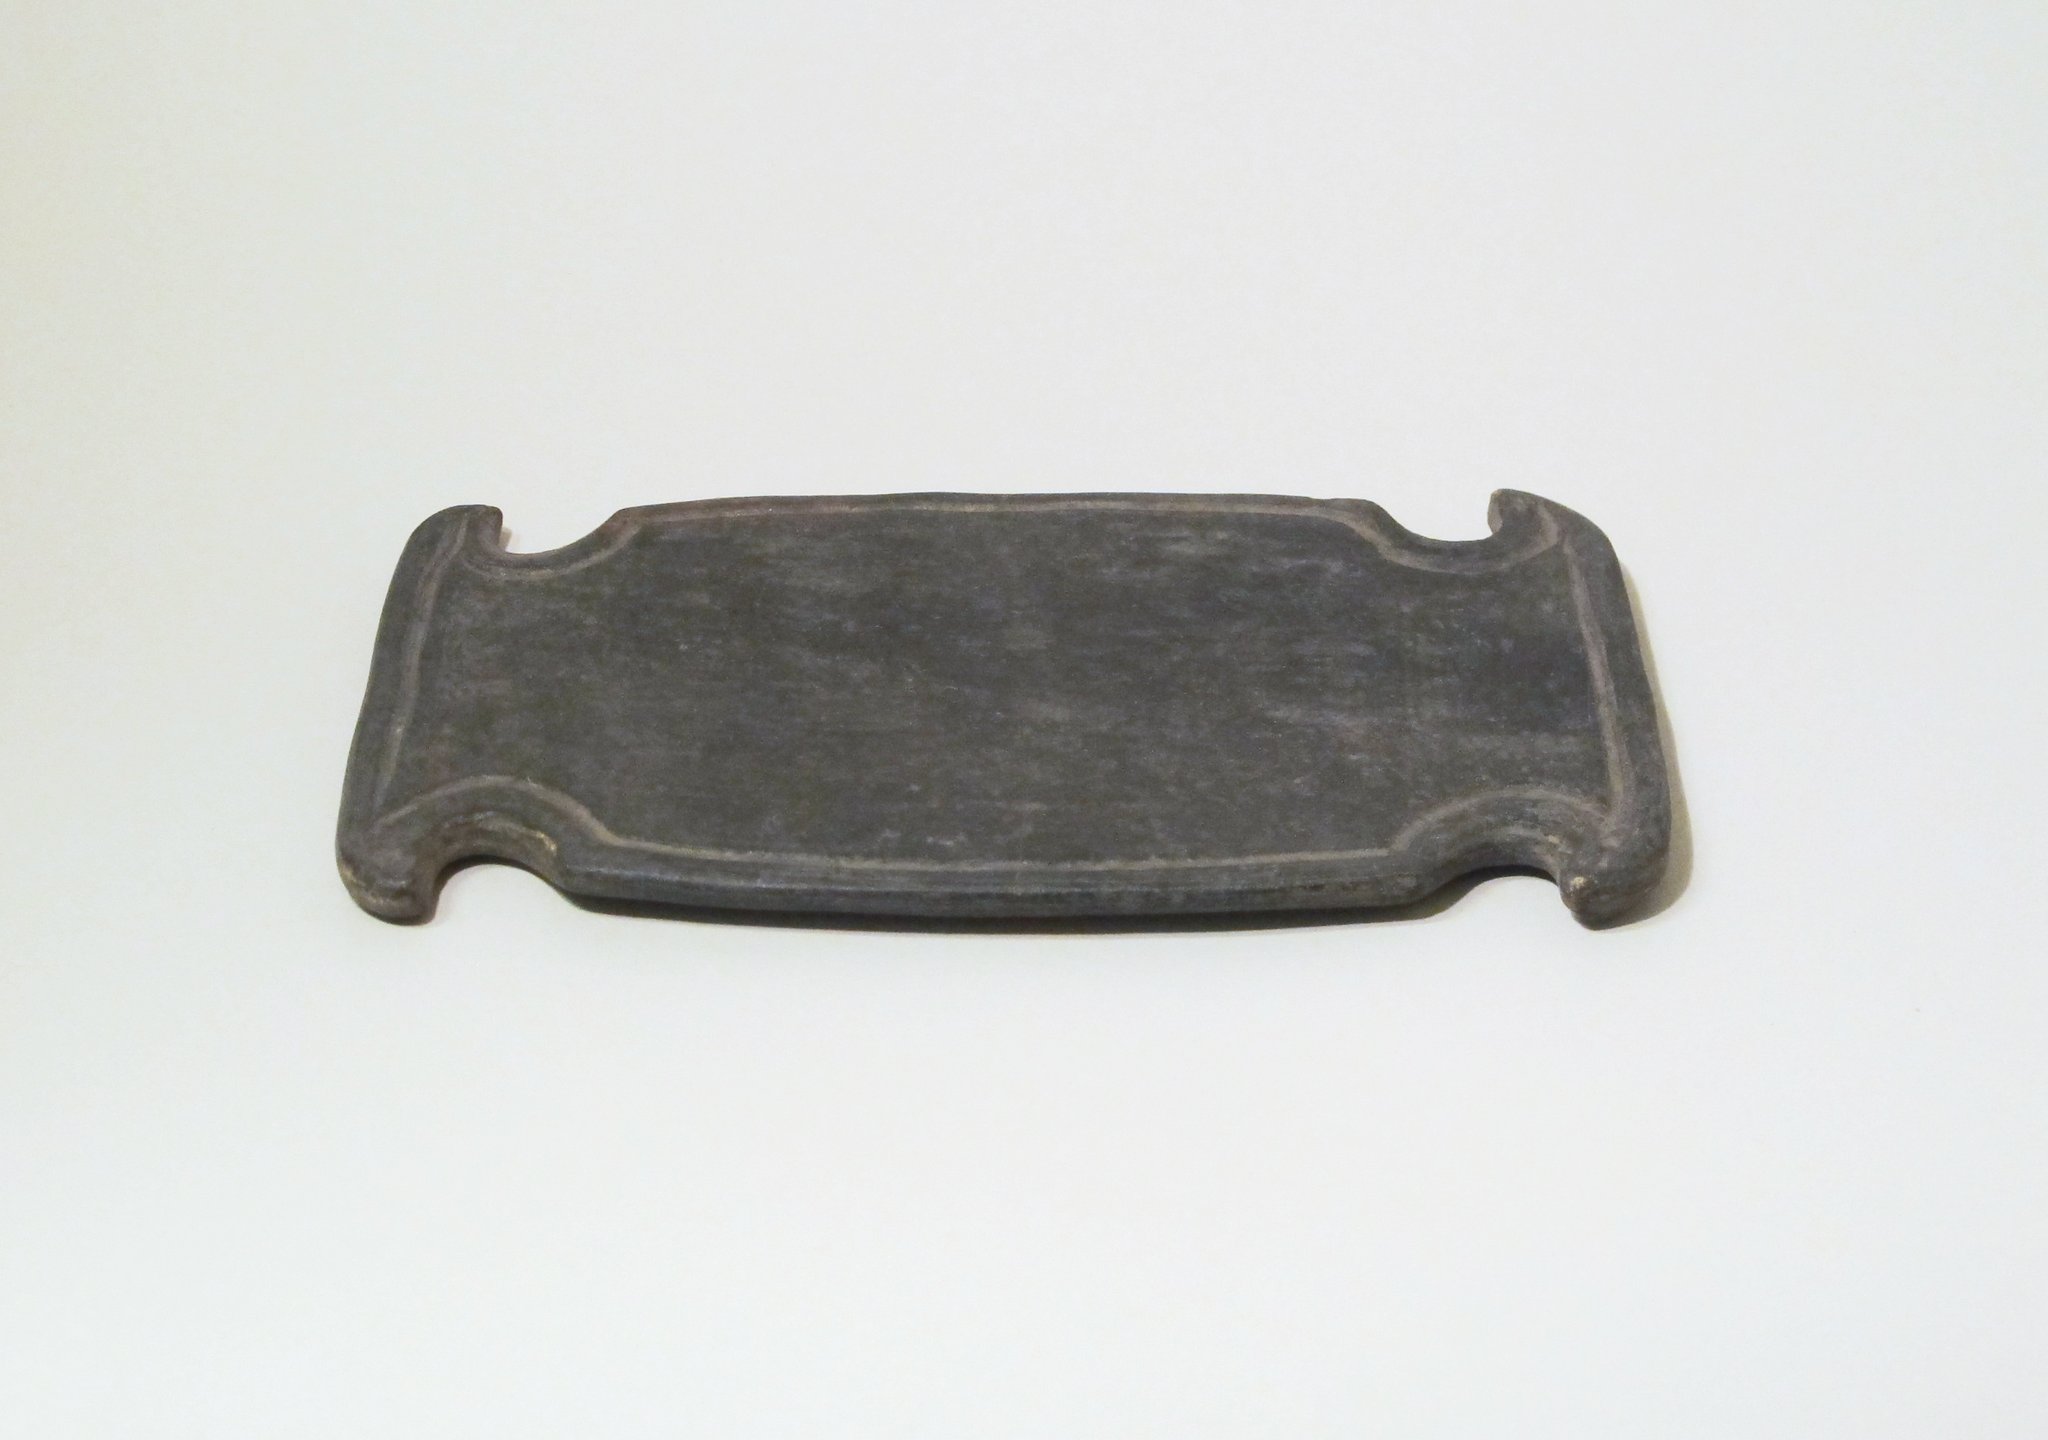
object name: focolare tablet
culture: etruscan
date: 550-501 BCE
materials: terracotta